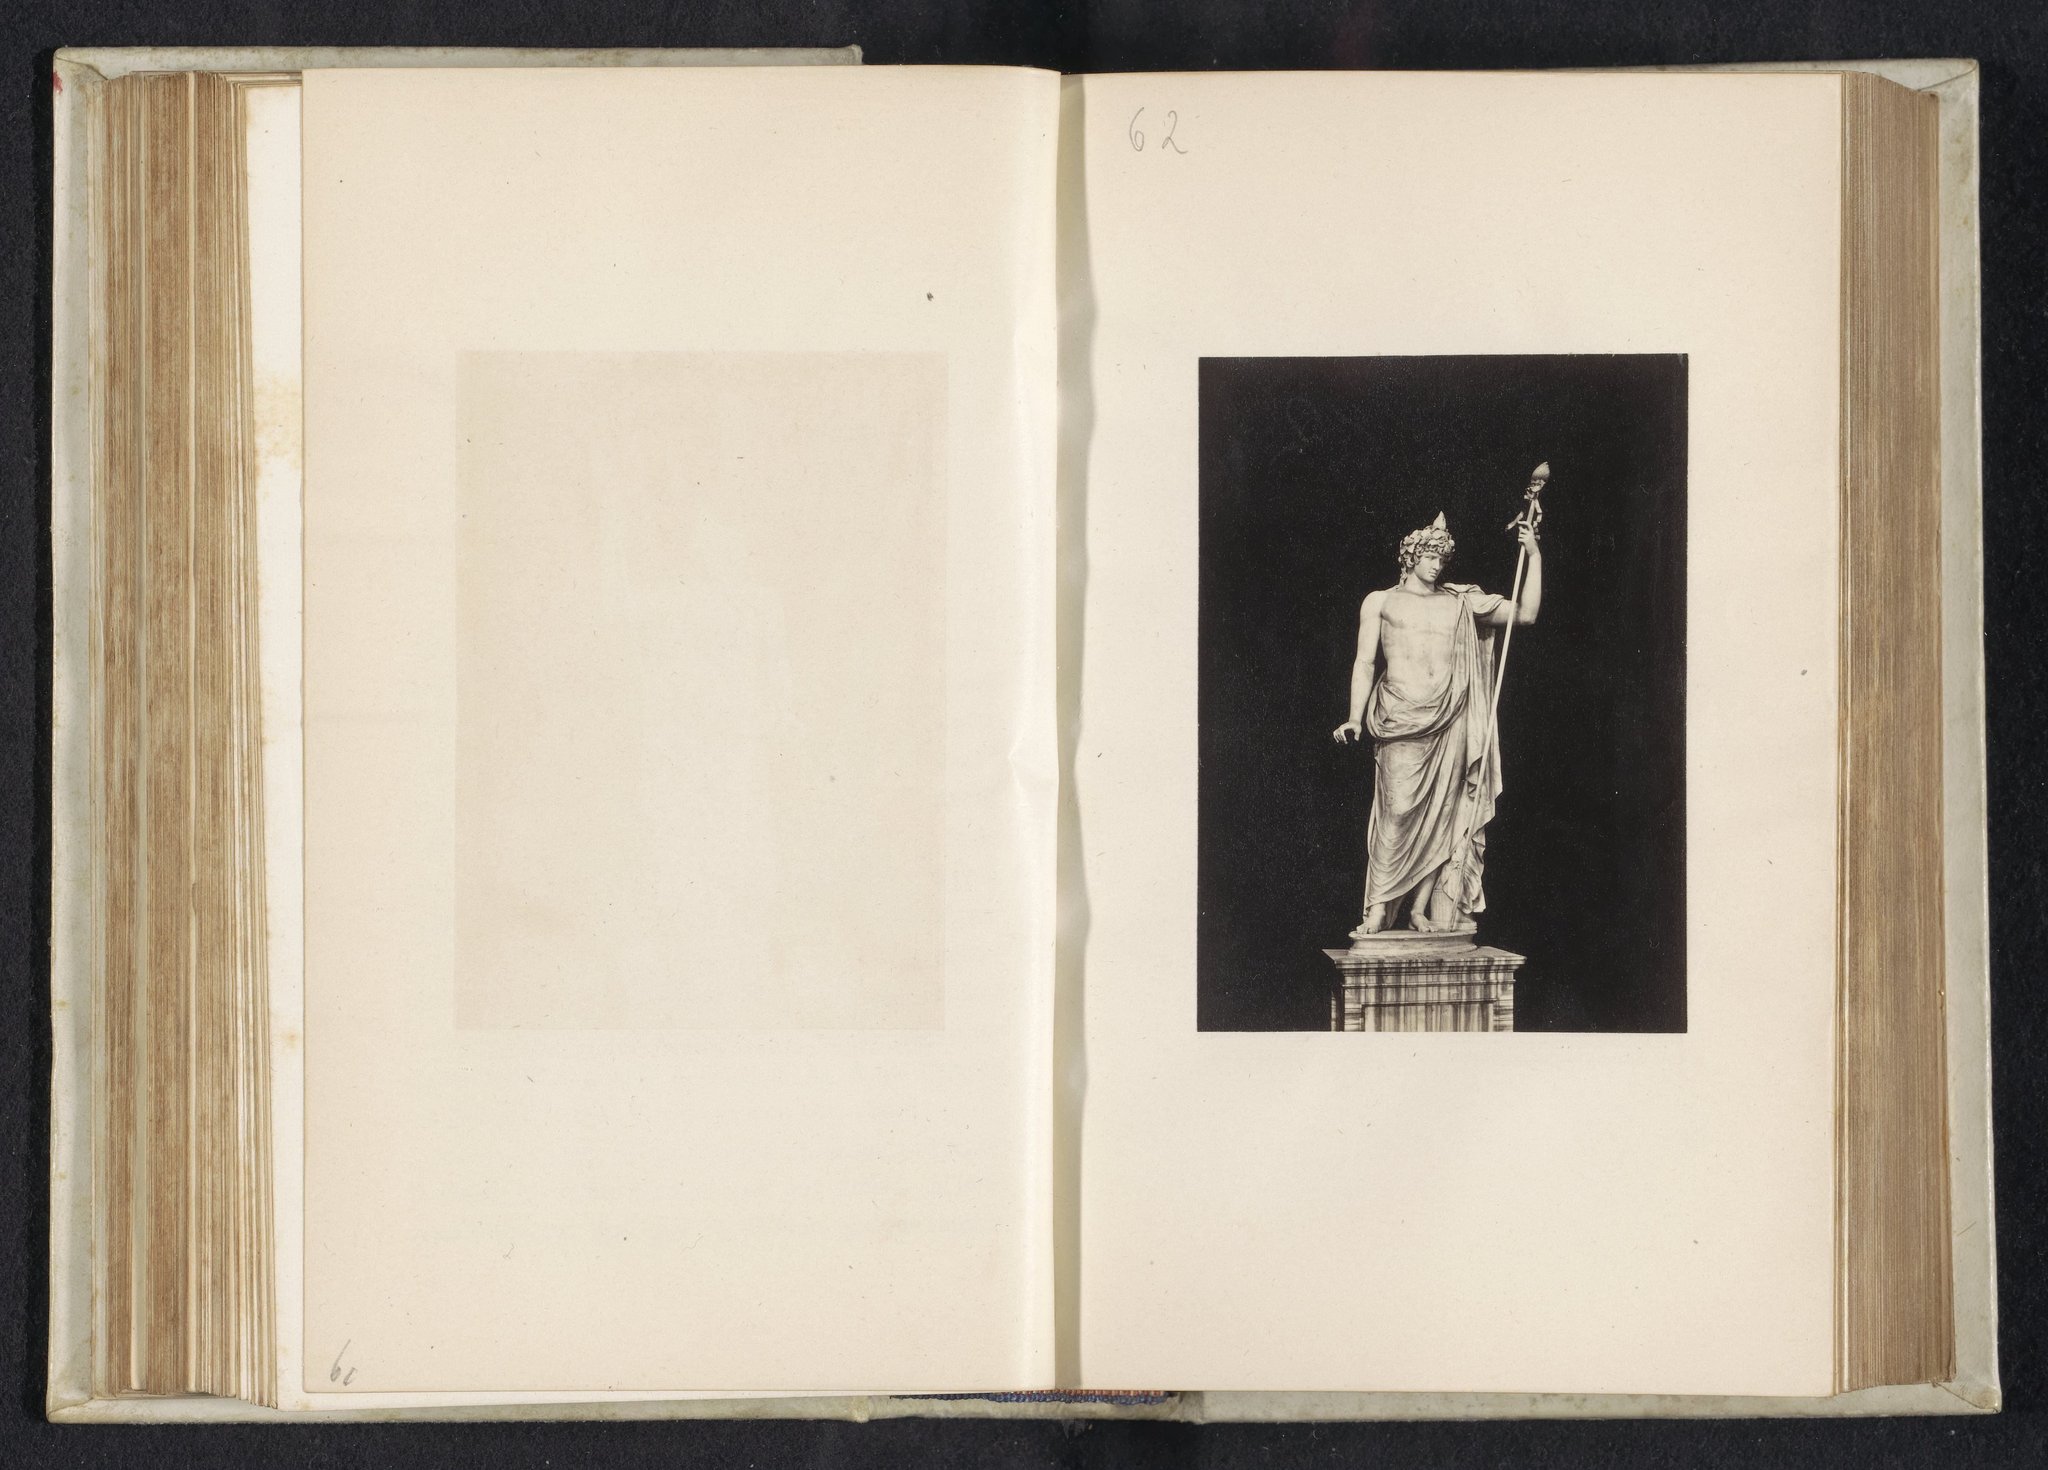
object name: photograph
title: Standbeeld van Antinoüs als Dionysos in de Vaticaanse Musea te Vaticaanstad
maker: Anonymous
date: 1850-1860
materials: photographic support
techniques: albumen print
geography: vatican museums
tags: (story of) bacchus (dionysus), liber, sculpture